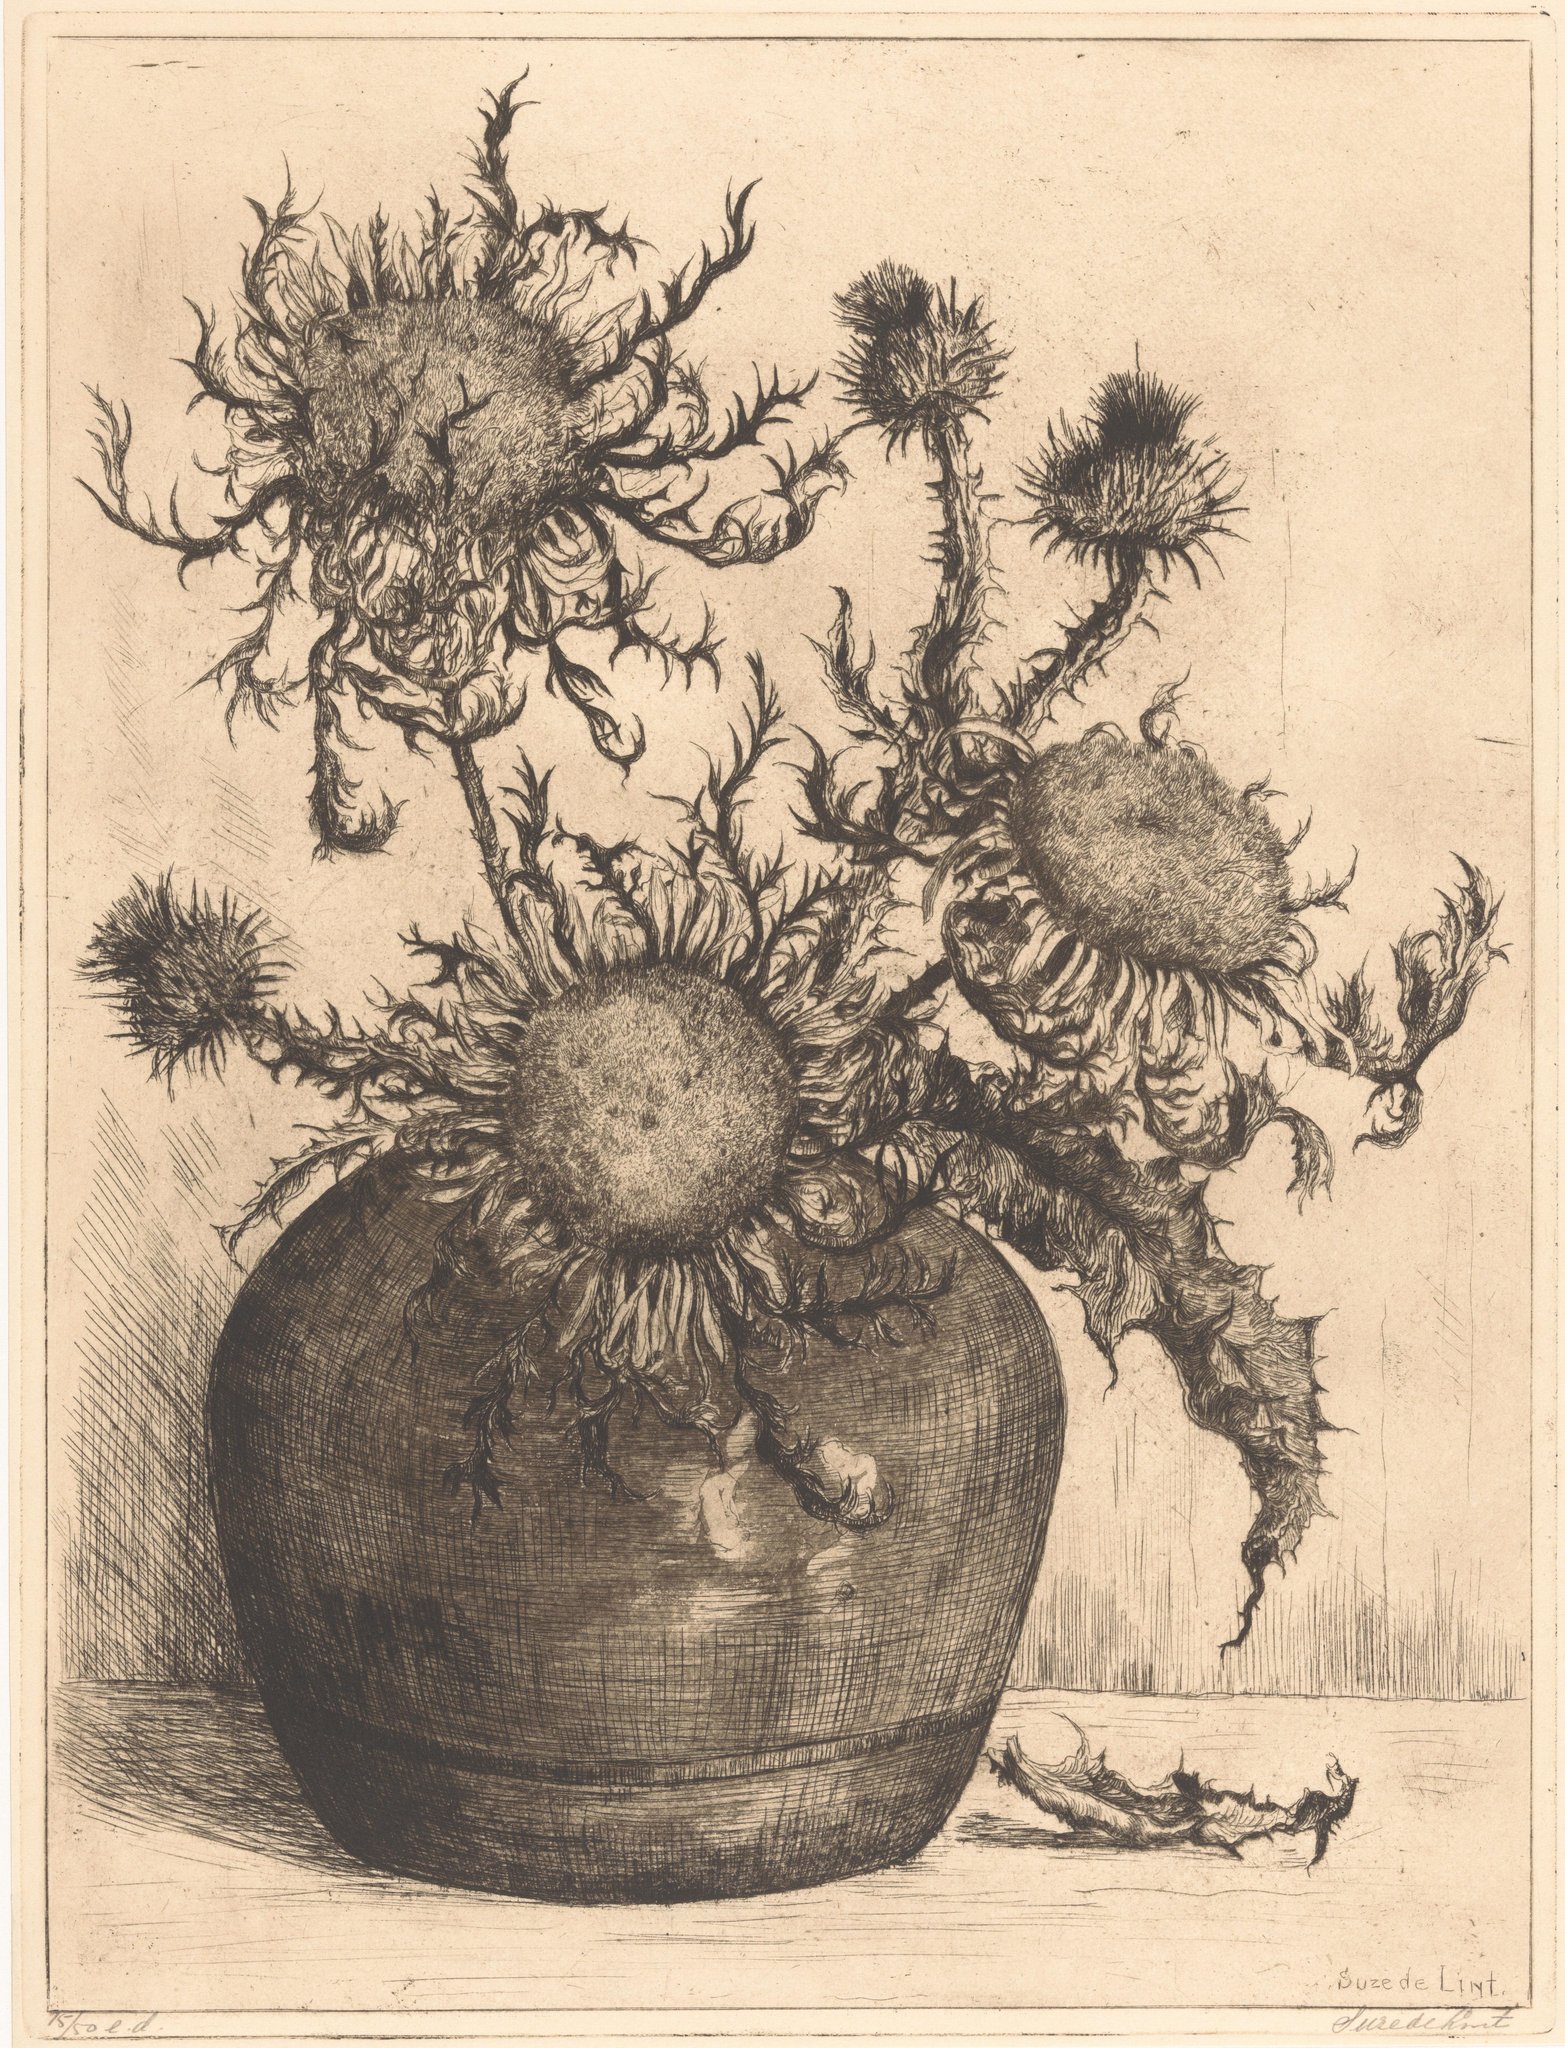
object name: print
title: Distels in vaas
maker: suze de lint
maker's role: print maker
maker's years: 1878-1953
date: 1888-1931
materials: paper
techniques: etching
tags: flowers in a vase, plants and herbs: thistle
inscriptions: collector's mark: Lugt 2228